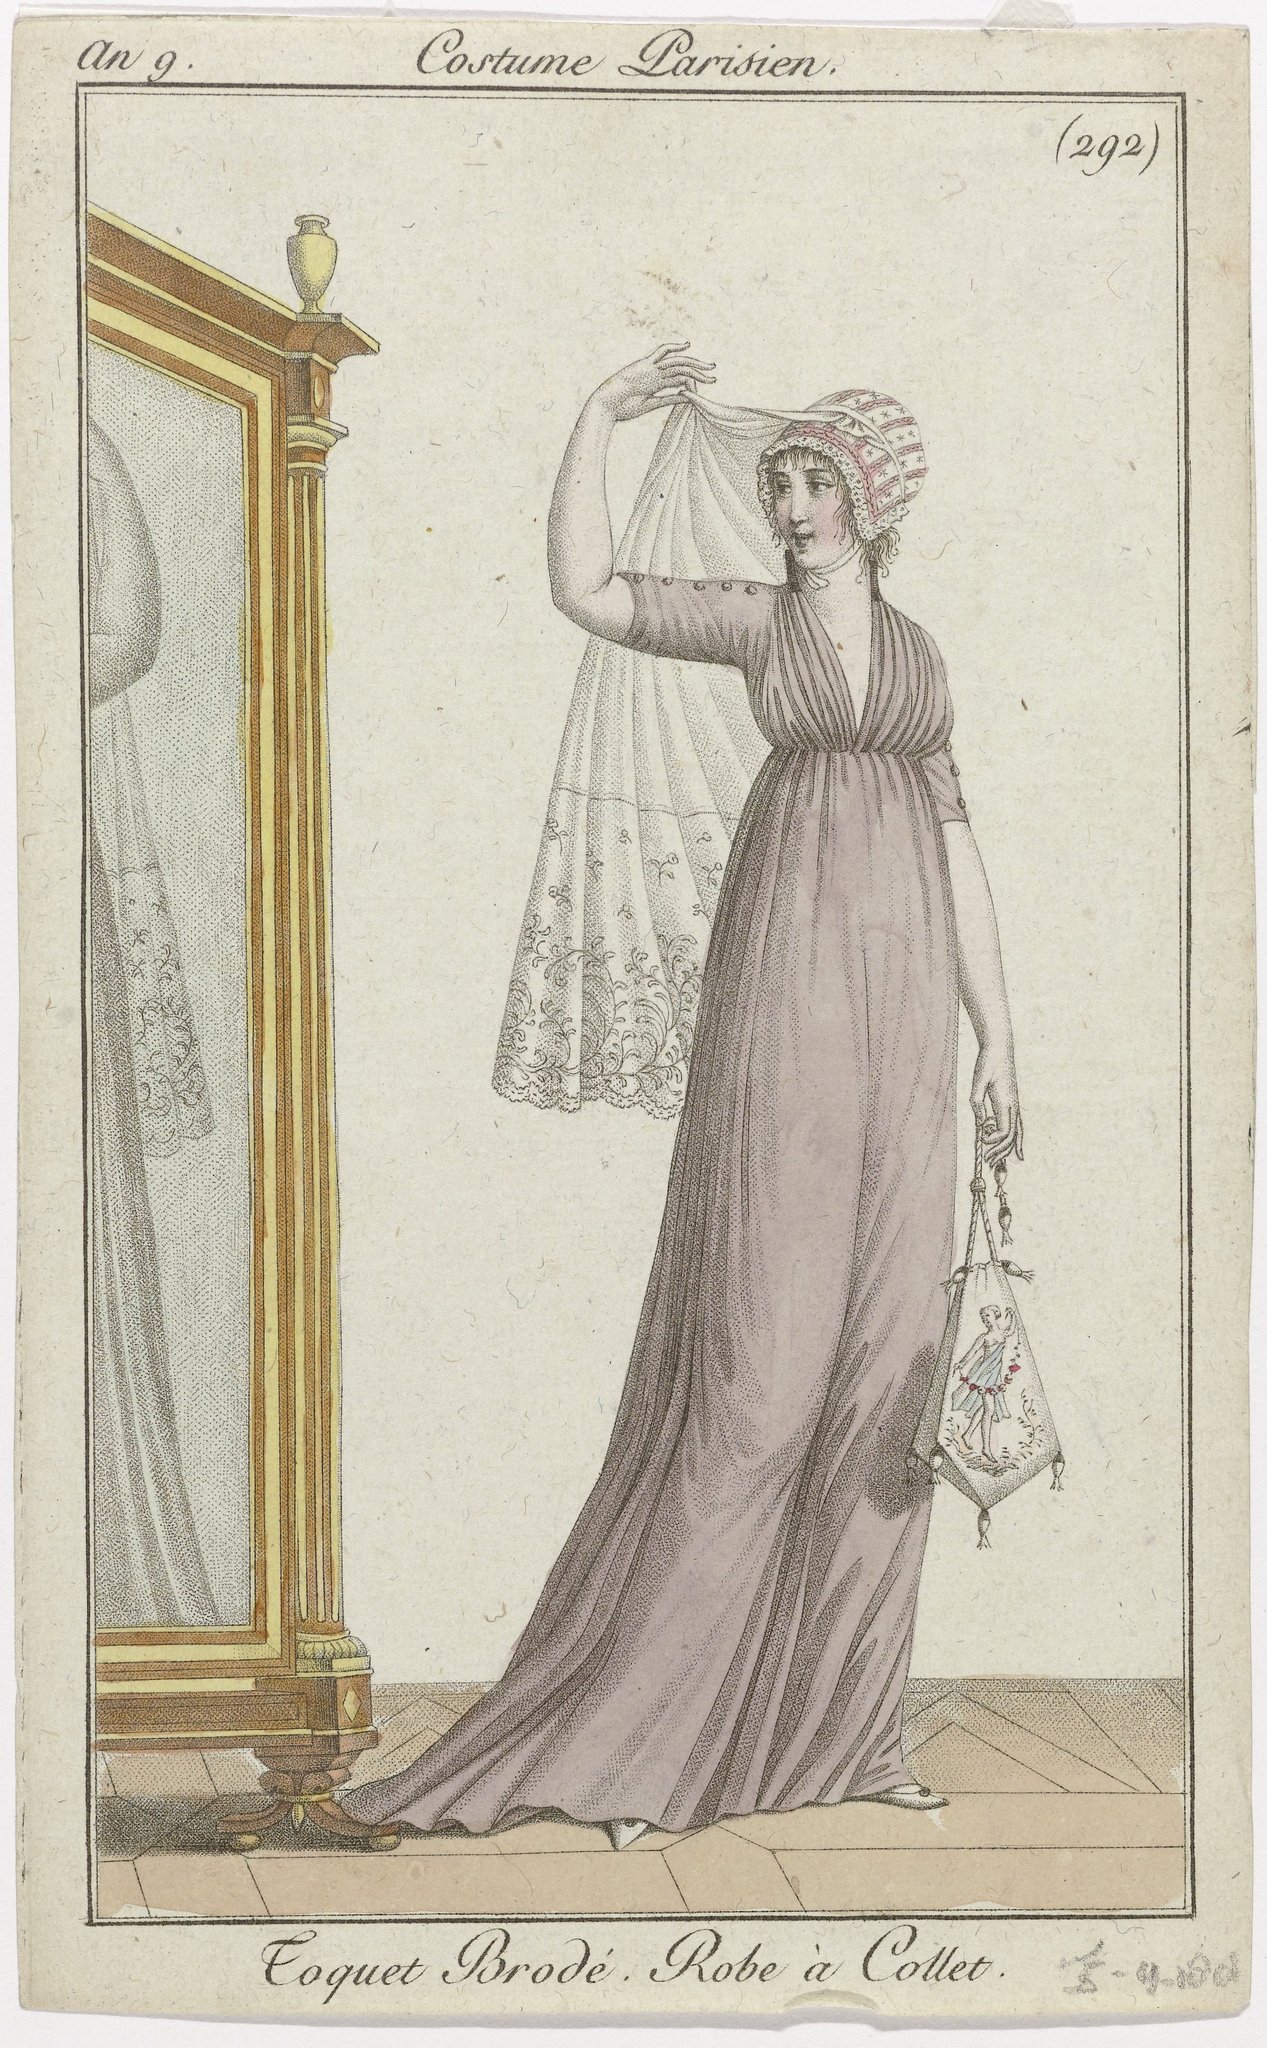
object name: fashion print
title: Journal des Dames et des Modes, Costume Parisien, 5 avril 1801, An 9, (292) : Toquet Brodé (...)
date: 1801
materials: paper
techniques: engraving, hand coloring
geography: paris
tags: looking in the mirror; (possibly: contemplation of own beauty - aa - (for) women), head-gear: toque (+ women's clothes), veil (+ women's clothes), bag (reticule) (+ women's clothes), mirror, fashion plates, shoes, sandals (+ women's clothes), dress, gown (+ women's clothes)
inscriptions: title: ‘Costume Parisien.’, caption: ‘Toquet Brodé. Robe à Collet.’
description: Staande vrouw, naast een passpiegel, met op het hoofd een 'toquet' met borduurwerk. Sluier met bloempatroon. Zij draagt een japon met opstaande kraag en sleep. Verdere accessoires: reticule met vrouwenfiguur, platte schoenen met puntige neuzen. De prent maakt deel uit van het modetijdschrift Journal des Dames et des Modes, uitgegeven door Pierre de la Mésangère, Parijs, 1797-1839.